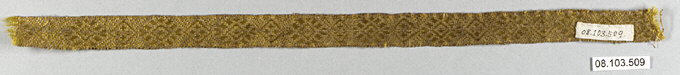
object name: galloon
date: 1701-1800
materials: cotton, silk